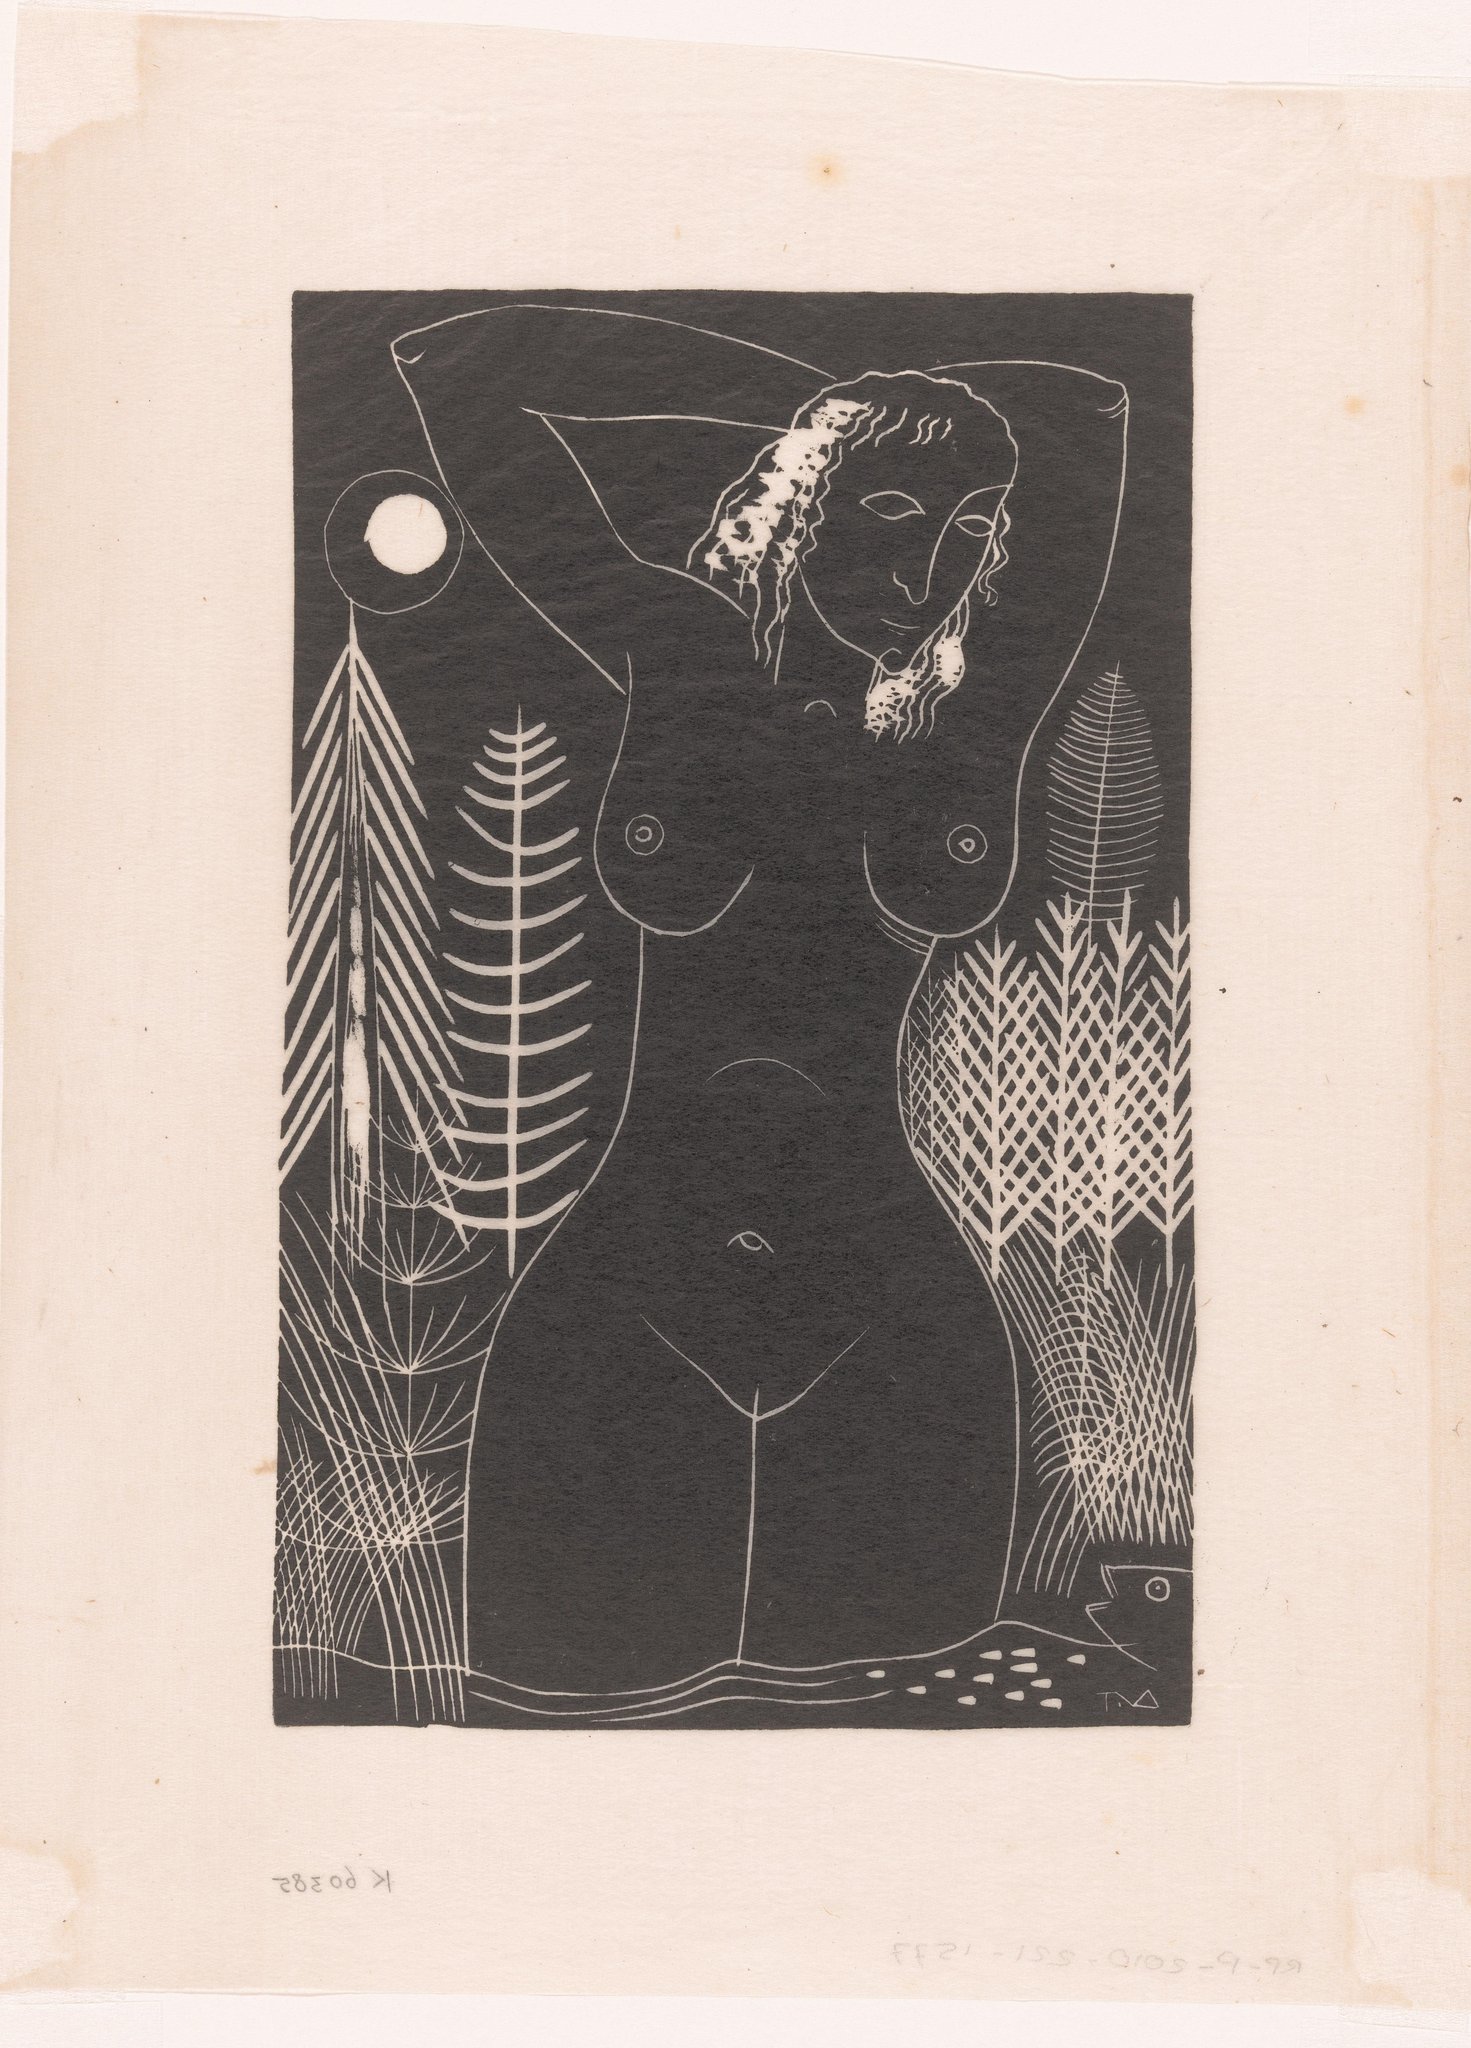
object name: print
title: Eva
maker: tinus van doorn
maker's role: painter, print maker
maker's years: 1905-1940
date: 1939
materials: paper, ink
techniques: linocut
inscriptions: monogram: ‘TVD’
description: Vrouwelijk naakt in water tussen planten, rechts een vis, in witte contouren tegen een zwart fond.